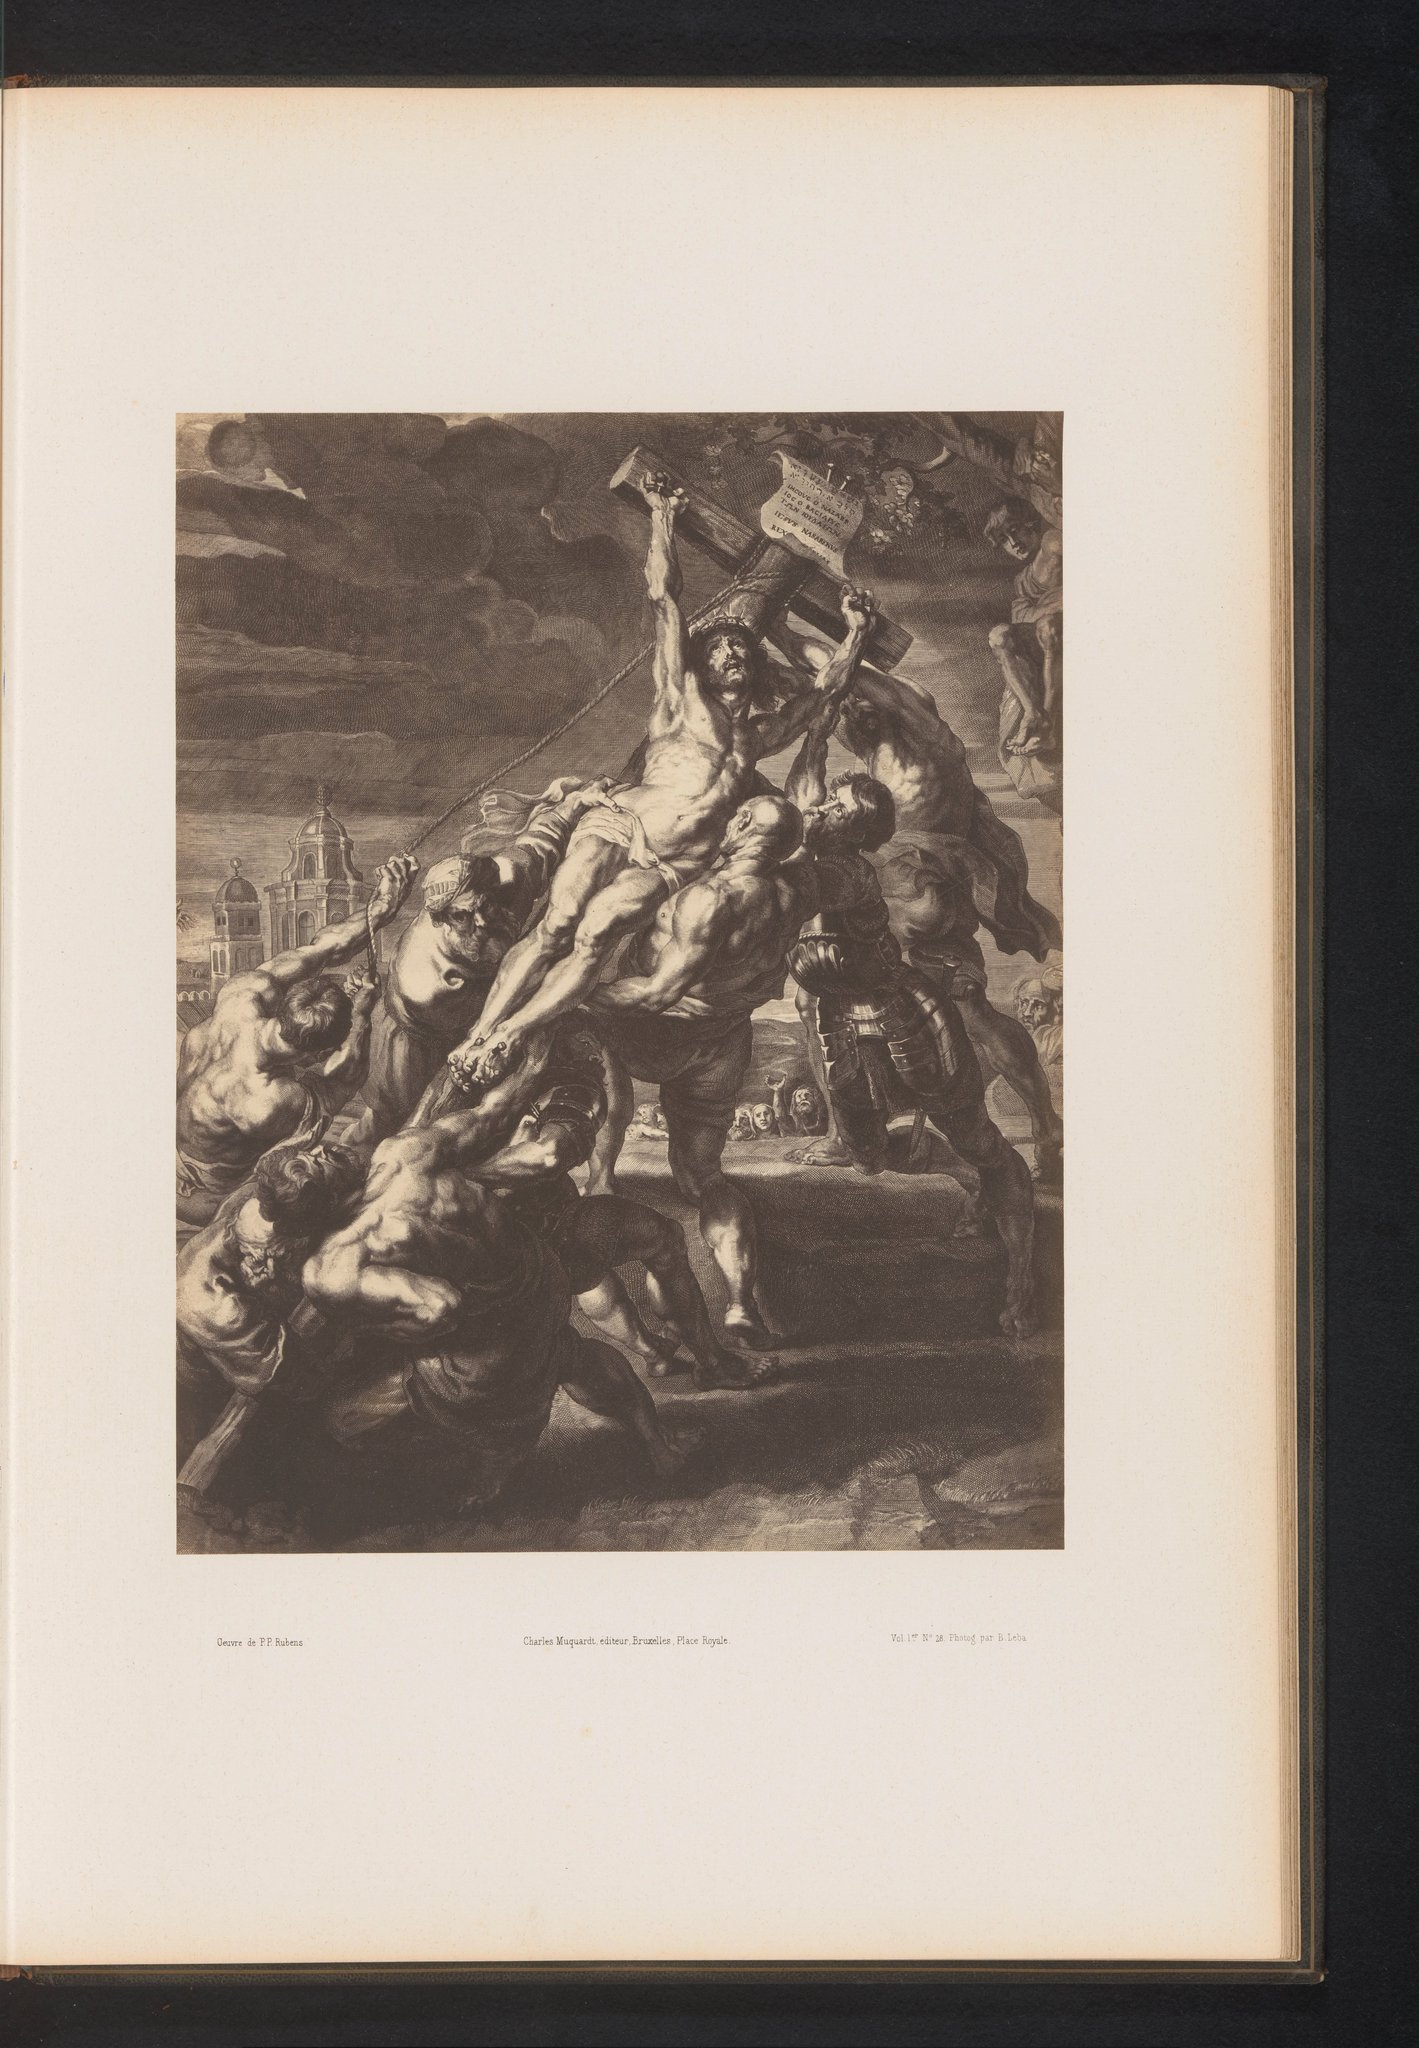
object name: photograph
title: Oeuvre de P.P. Rubens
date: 1853-1858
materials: photographic support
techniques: albumen print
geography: brussels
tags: christ is nailed to the erected cross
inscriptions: number: ‘Vol. 1er. No 28.’